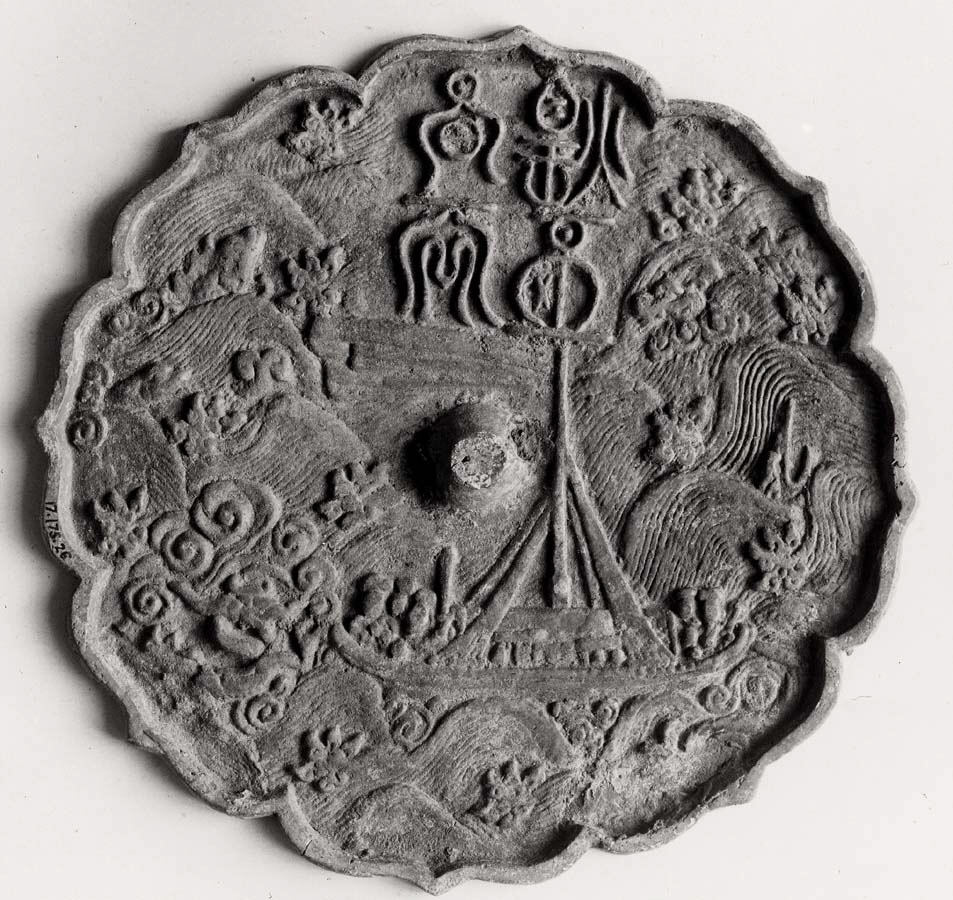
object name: mirror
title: Mirror decorated with a ship in a stormy sea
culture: korean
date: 918-1392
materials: bronze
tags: boats